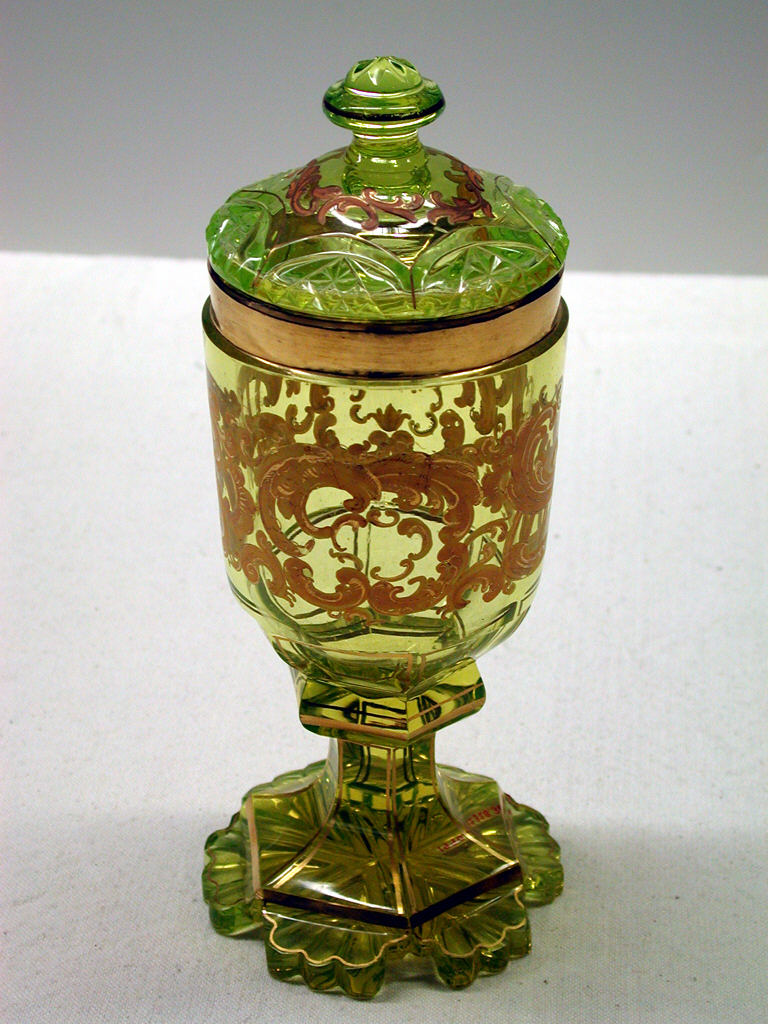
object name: goblet with cover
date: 1830-1840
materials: glass